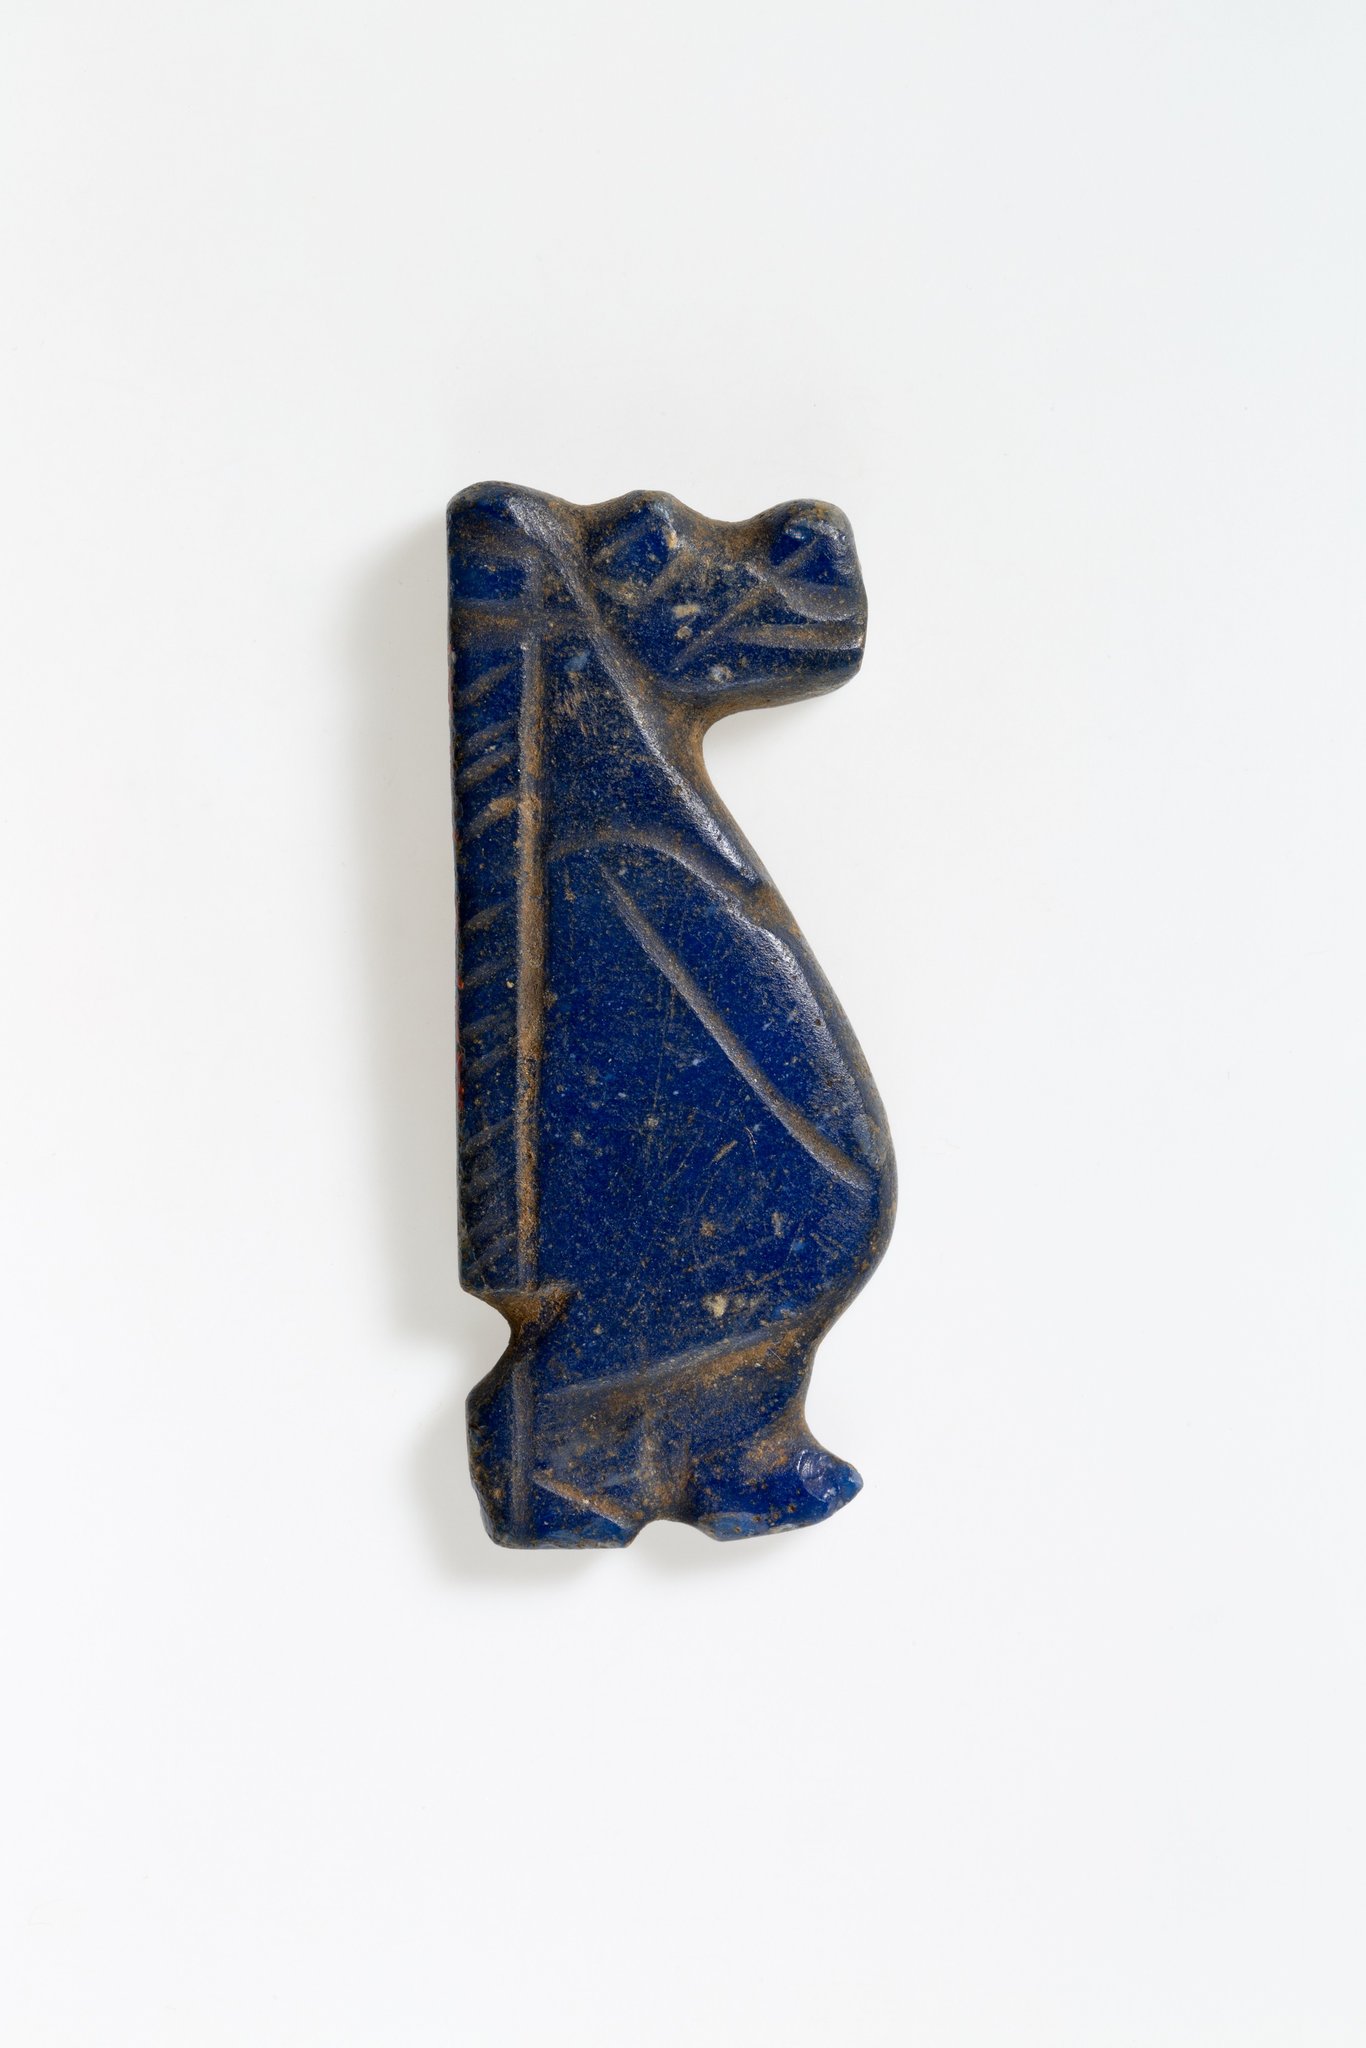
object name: amulet, taweret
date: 1550-1295 BCE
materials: lapis lazuli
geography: egypt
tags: taweret